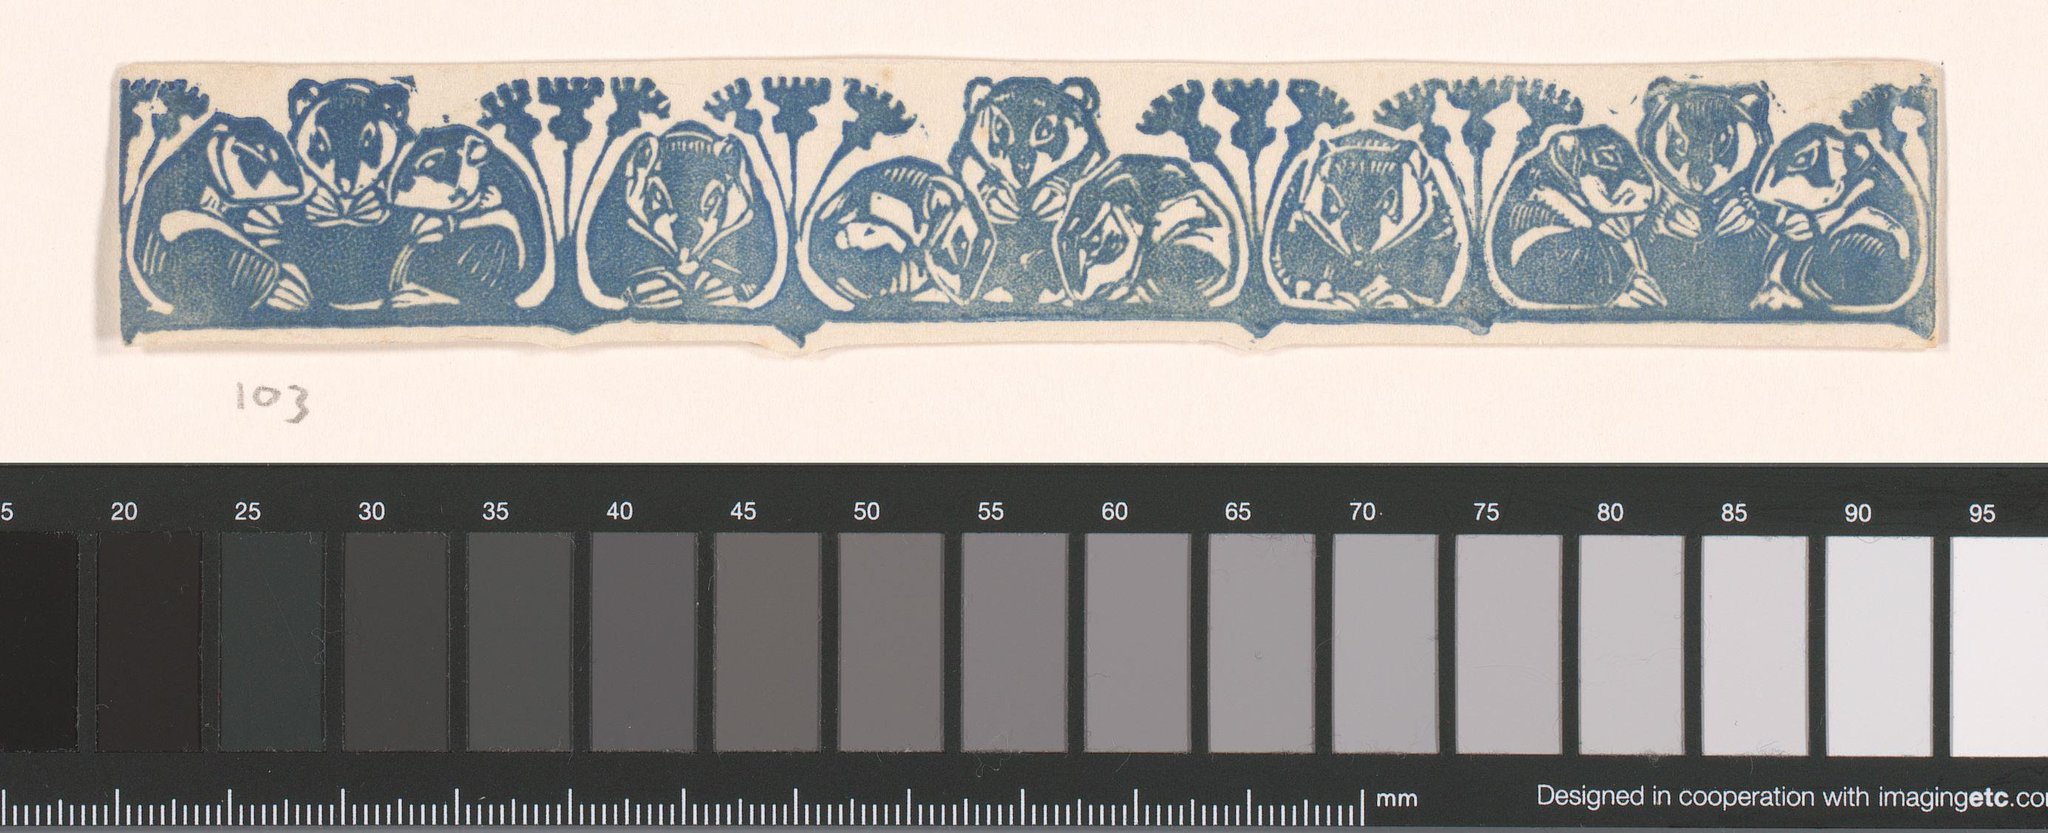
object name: boekillustratie ontwerp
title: Ornamentele rand met hamsters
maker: bernard willem wierink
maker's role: draughtsman, print maker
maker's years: 1856-1939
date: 1910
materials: paper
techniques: relief print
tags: rodents, fable of reynard the fox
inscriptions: collector's mark: Lugt 2228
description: Ontwerp voor: Streuvels, Stijn (Frank Lateur). Reinaert de Vos naar verschillende uitgaven van het middeleeuwsche epos. Amsterdam: L.J. Veen, 1910. Deze prent is vermoedelijk een plaatsnede, ook al wordt in de literatuur veelal gesproken over een houtsnede. Voor zover Wierink zijn prenten in hoogdruk zelf nader heeft omschreven, heeft hij altijd de term 'plaatsnede' gebruikt.